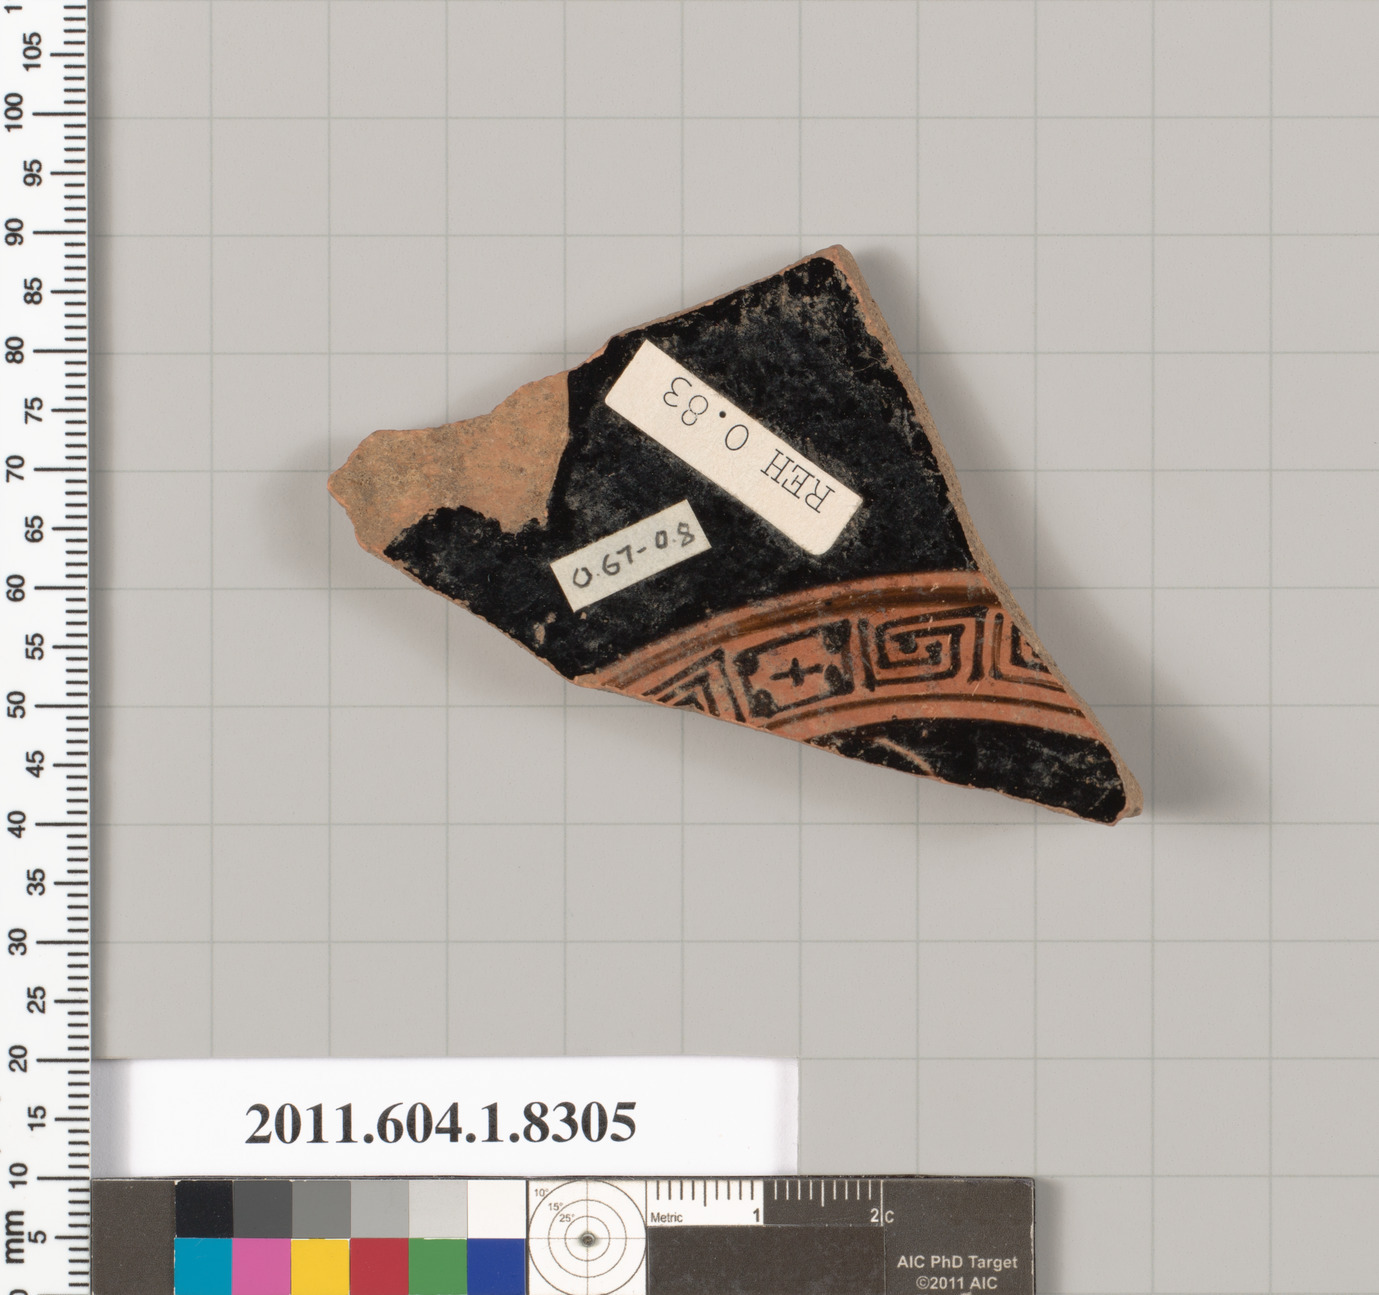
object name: kylix fragment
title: Terracotta fragment of a kylix (drinking cup)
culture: greek, attic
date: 400 BCE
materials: terracotta